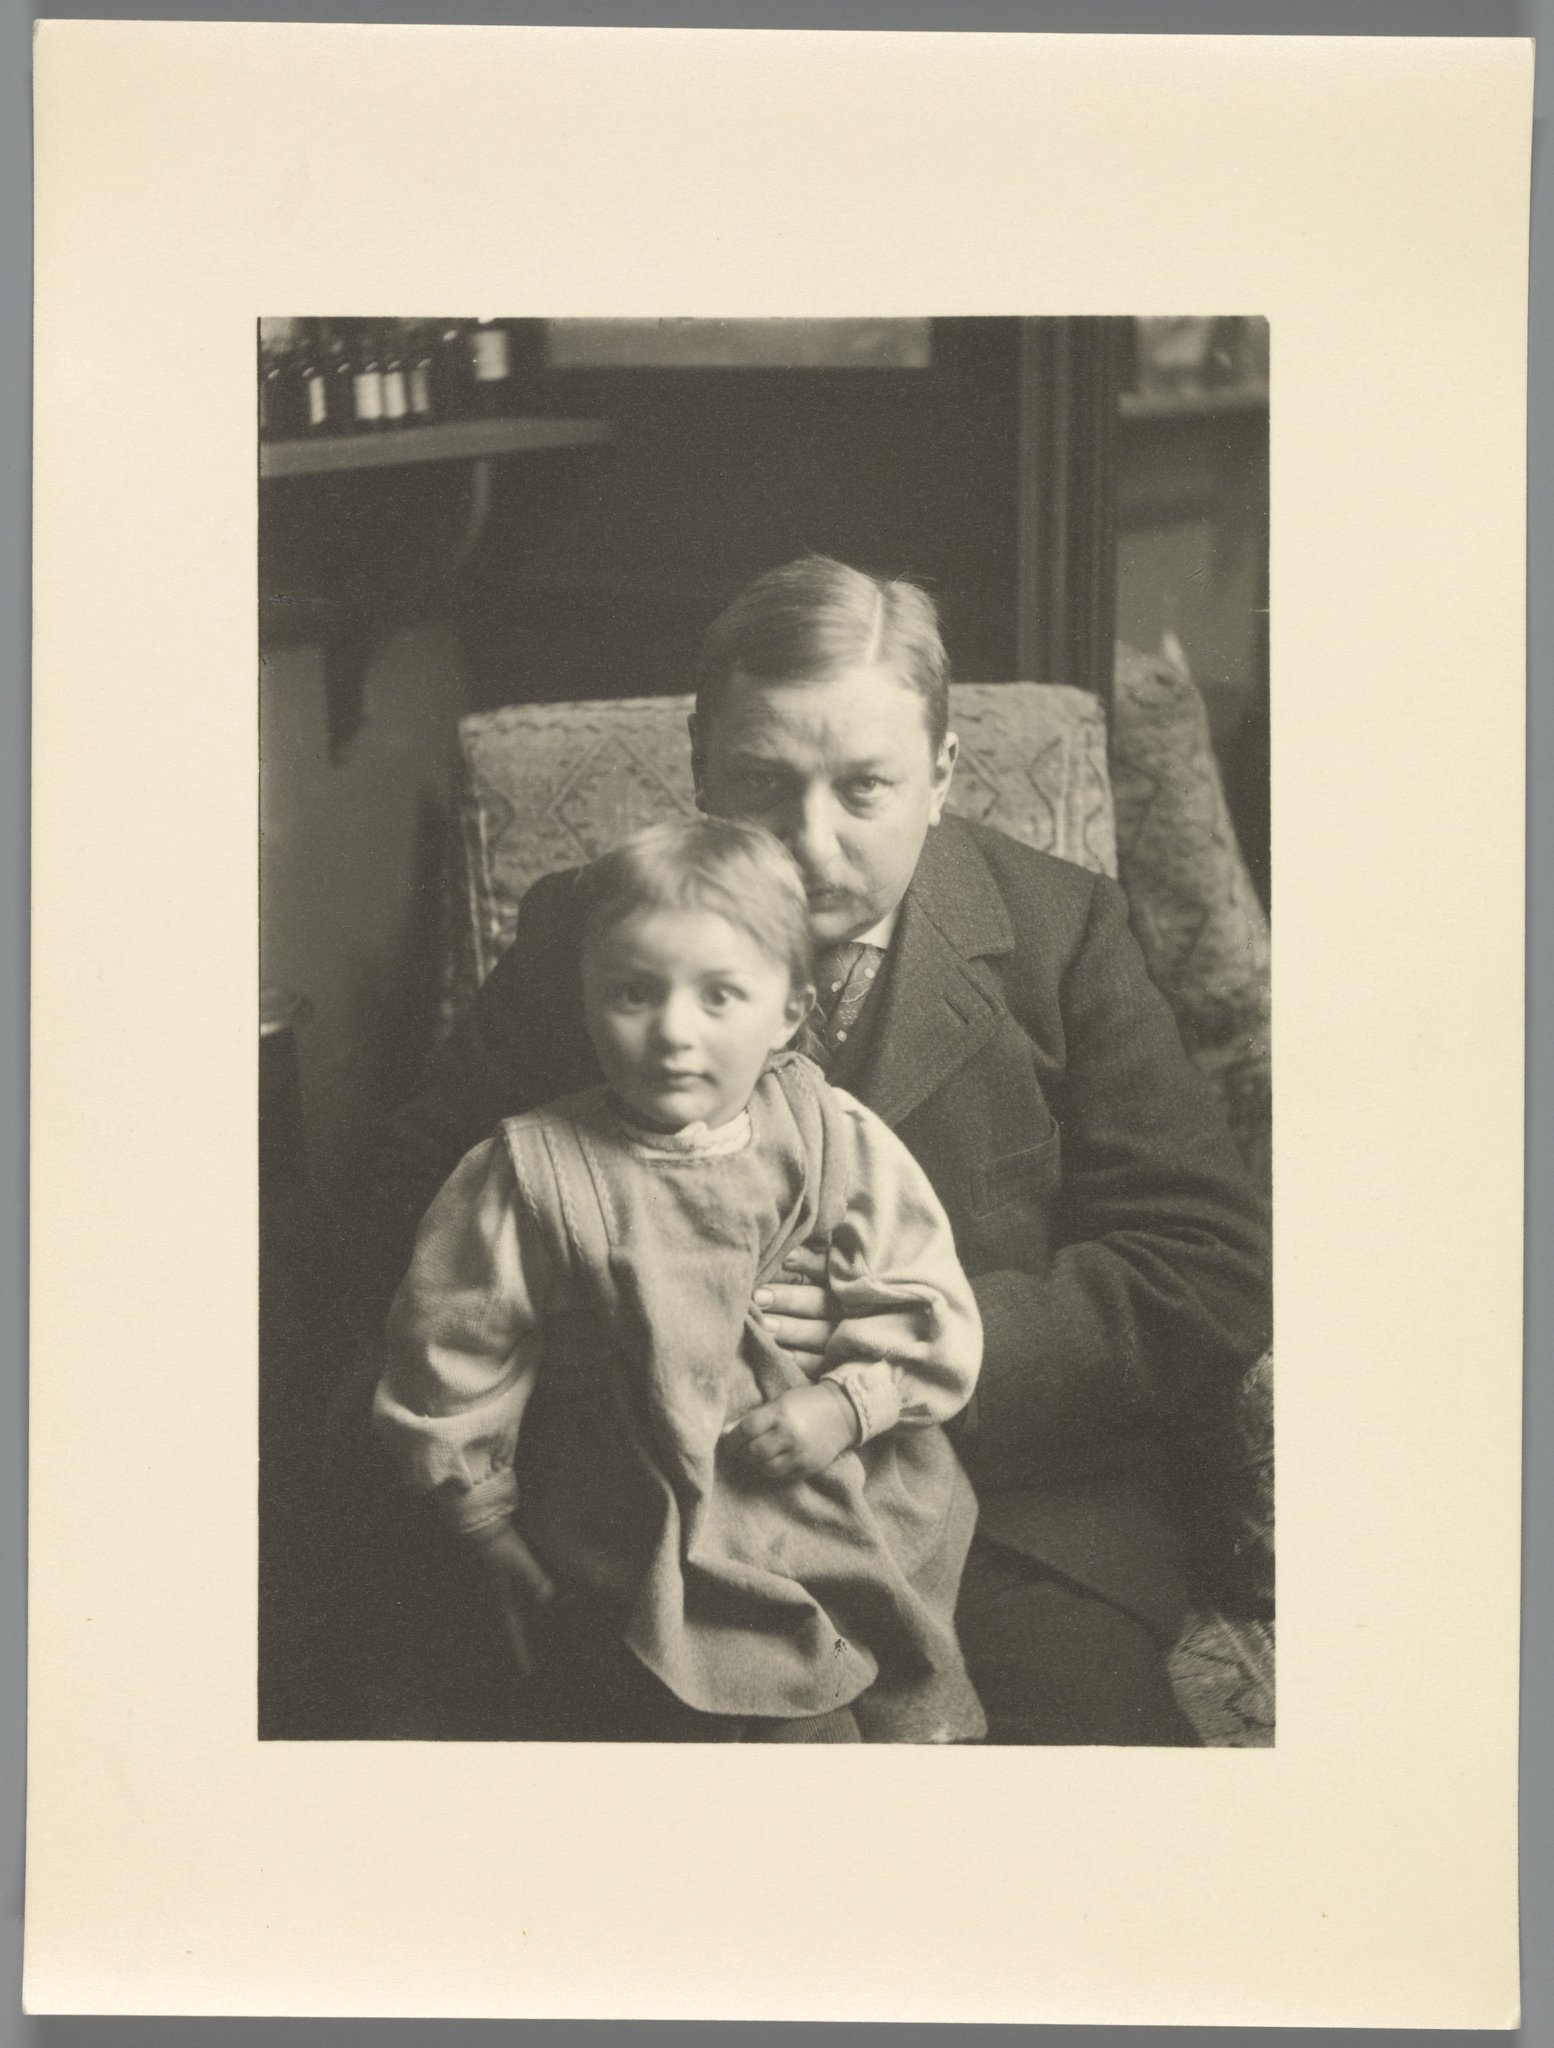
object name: photograph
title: Reproductie naar een foto van Willem Witsen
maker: Anonymous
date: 1860-1915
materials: paper, photographic support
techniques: gelatin silver print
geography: netherlands